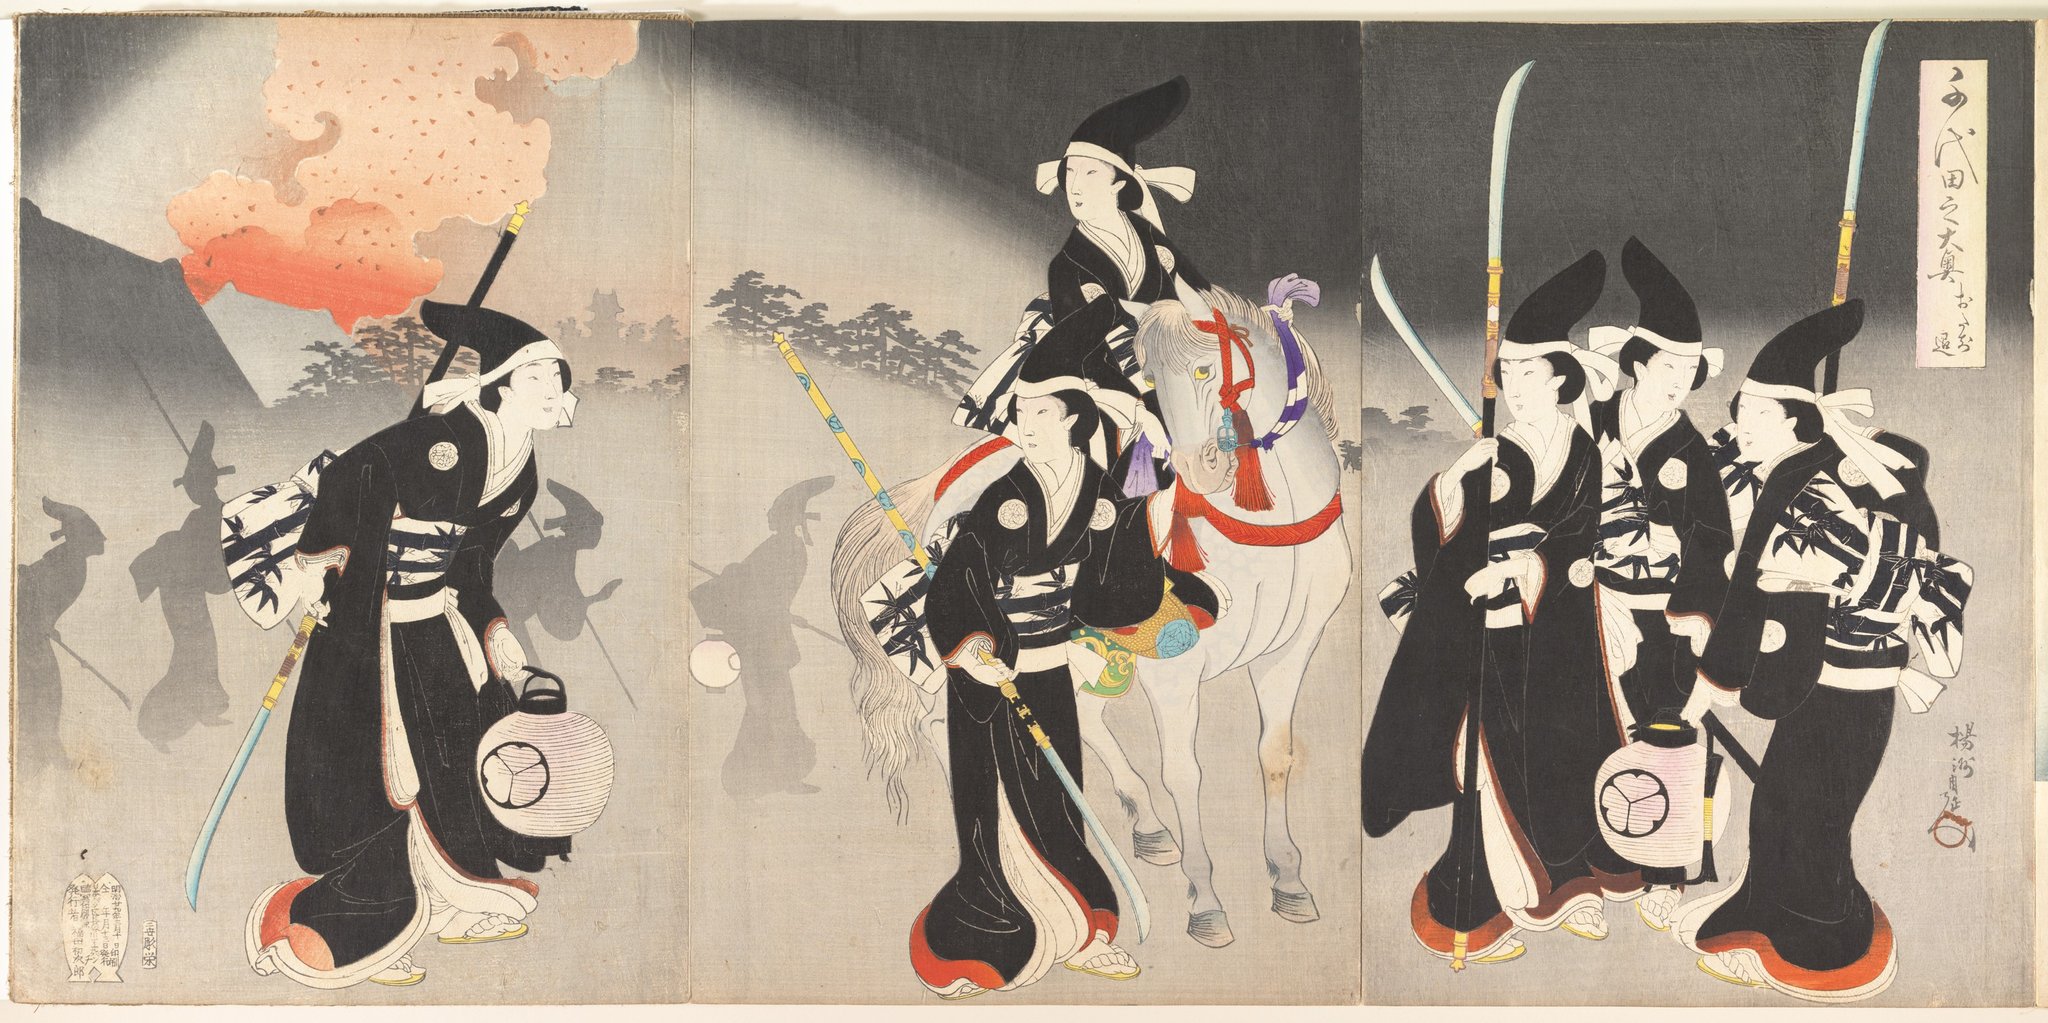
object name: print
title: “Evacuation of the Ladies,” from the series The Inner Precincts of Chiyoda Castle (Chiyoda no Ōoku, Otachinoki)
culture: japanese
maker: yōshū (hashimoto) chikanobu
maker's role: artist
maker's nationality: japanese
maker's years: 1838-1912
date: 1896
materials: ink, paper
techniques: nishiki e, woodblock print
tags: weapons,women,horses